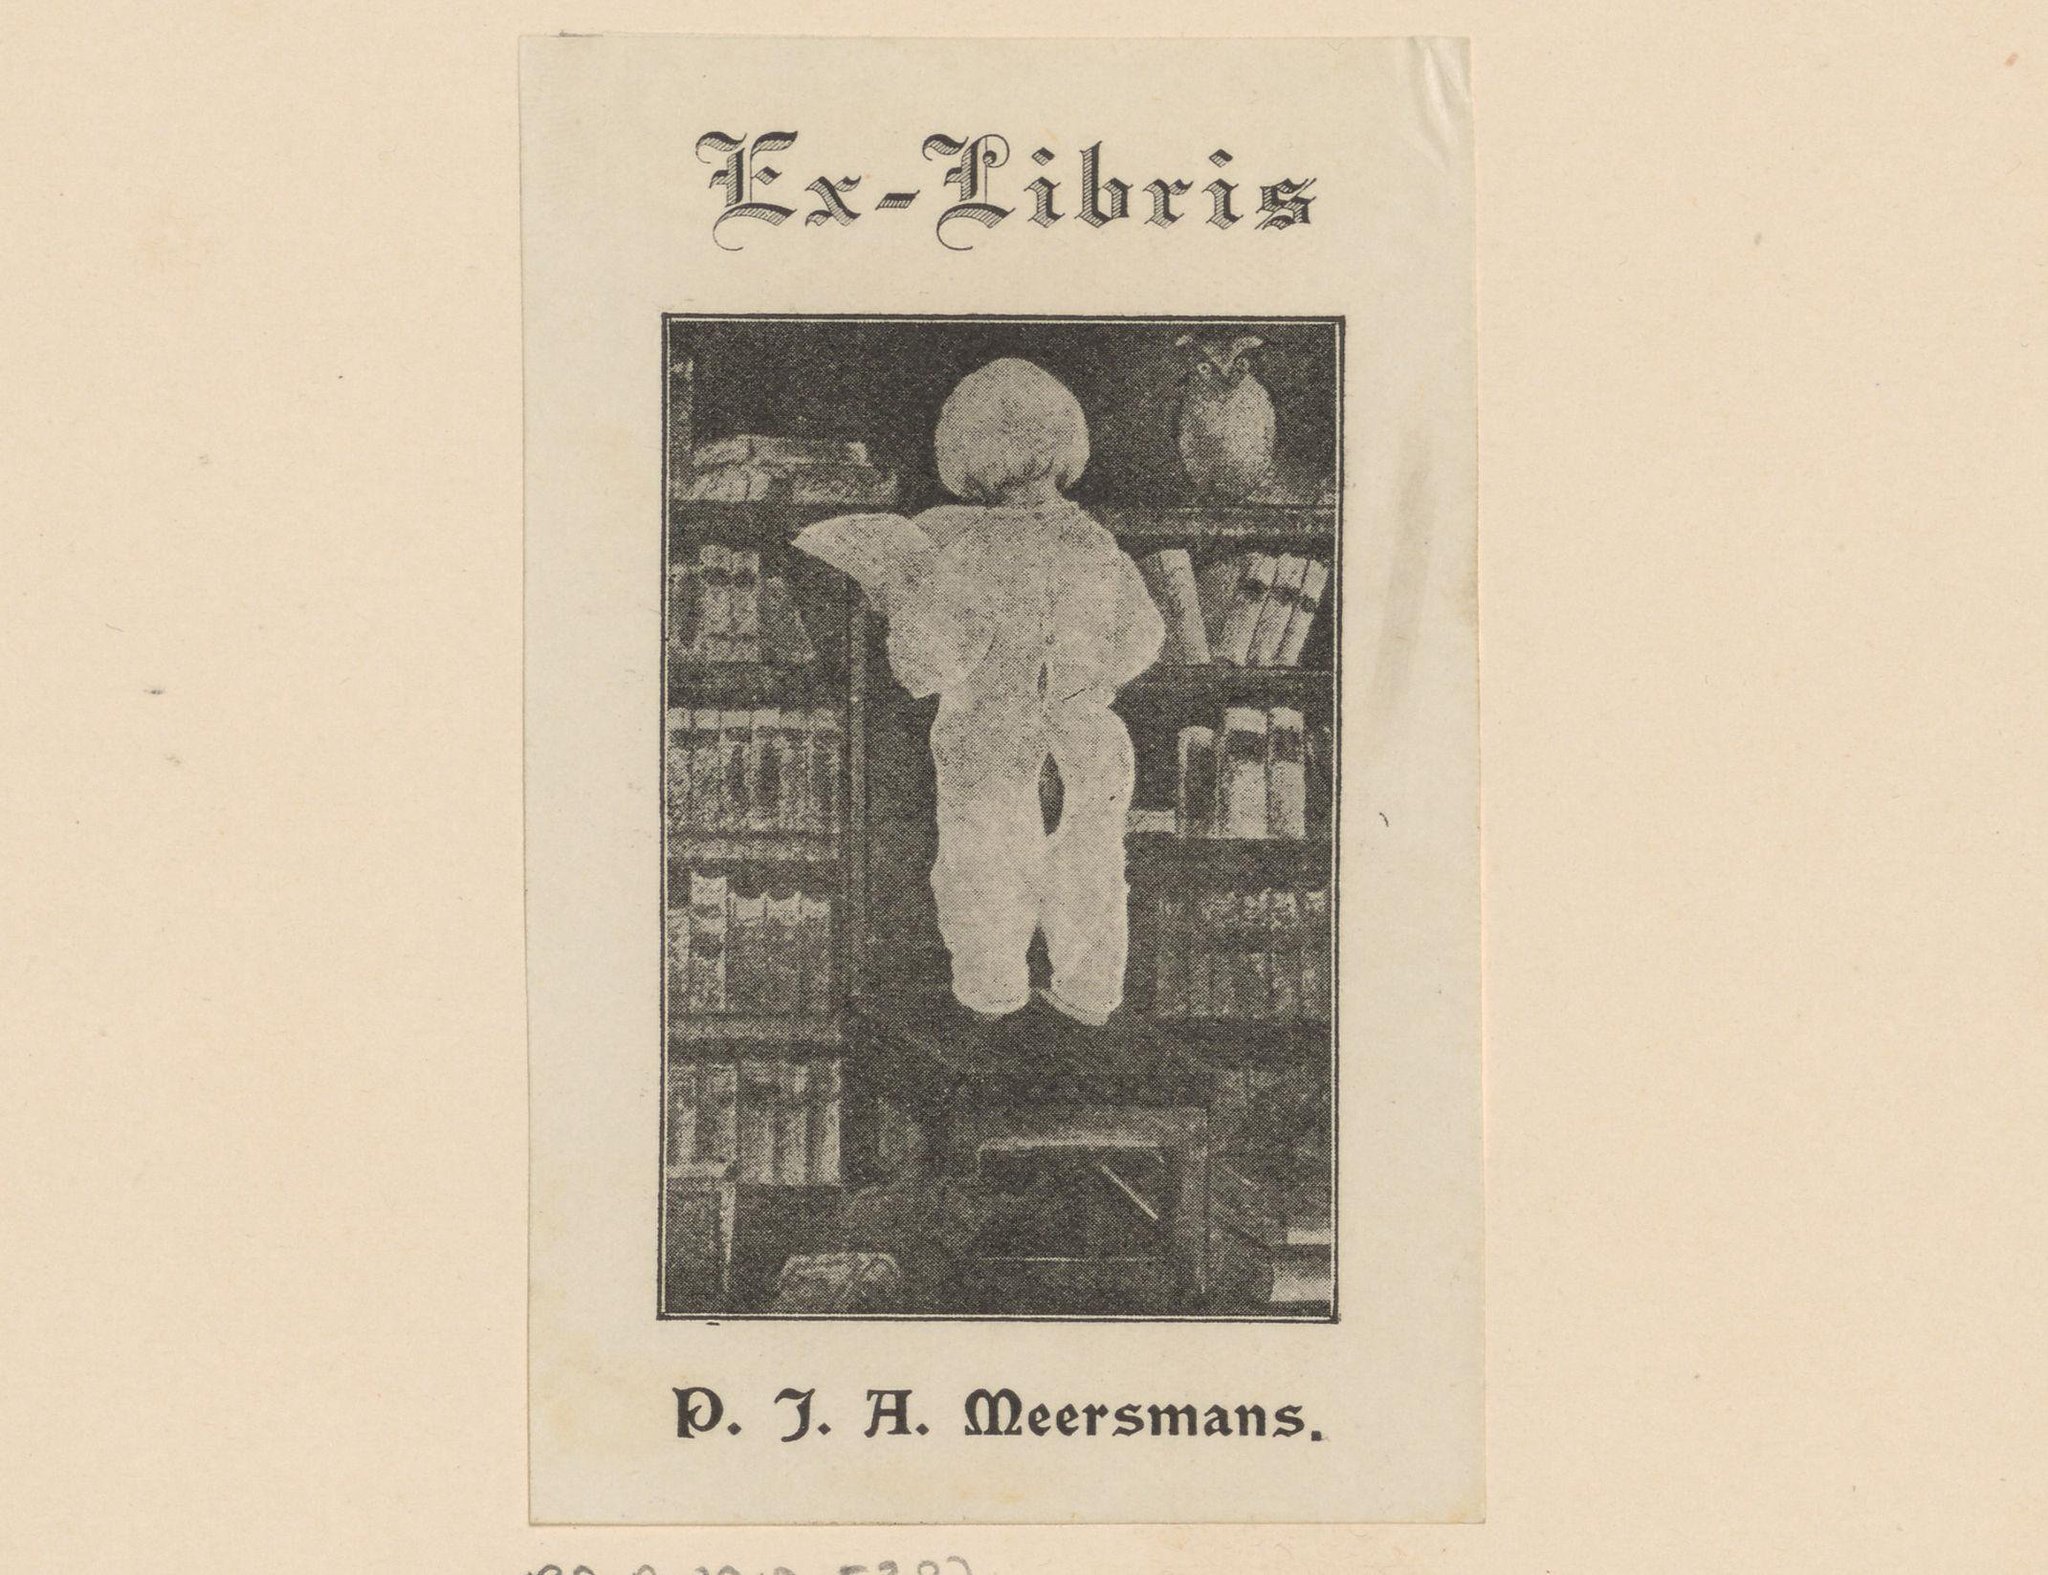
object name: bookplate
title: Ex libris van P.J.A. Meersmans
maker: Anonymous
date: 1900-1923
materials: paper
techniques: autotype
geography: netherlands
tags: bookshelves, reading, girl (child between toddler and youth)